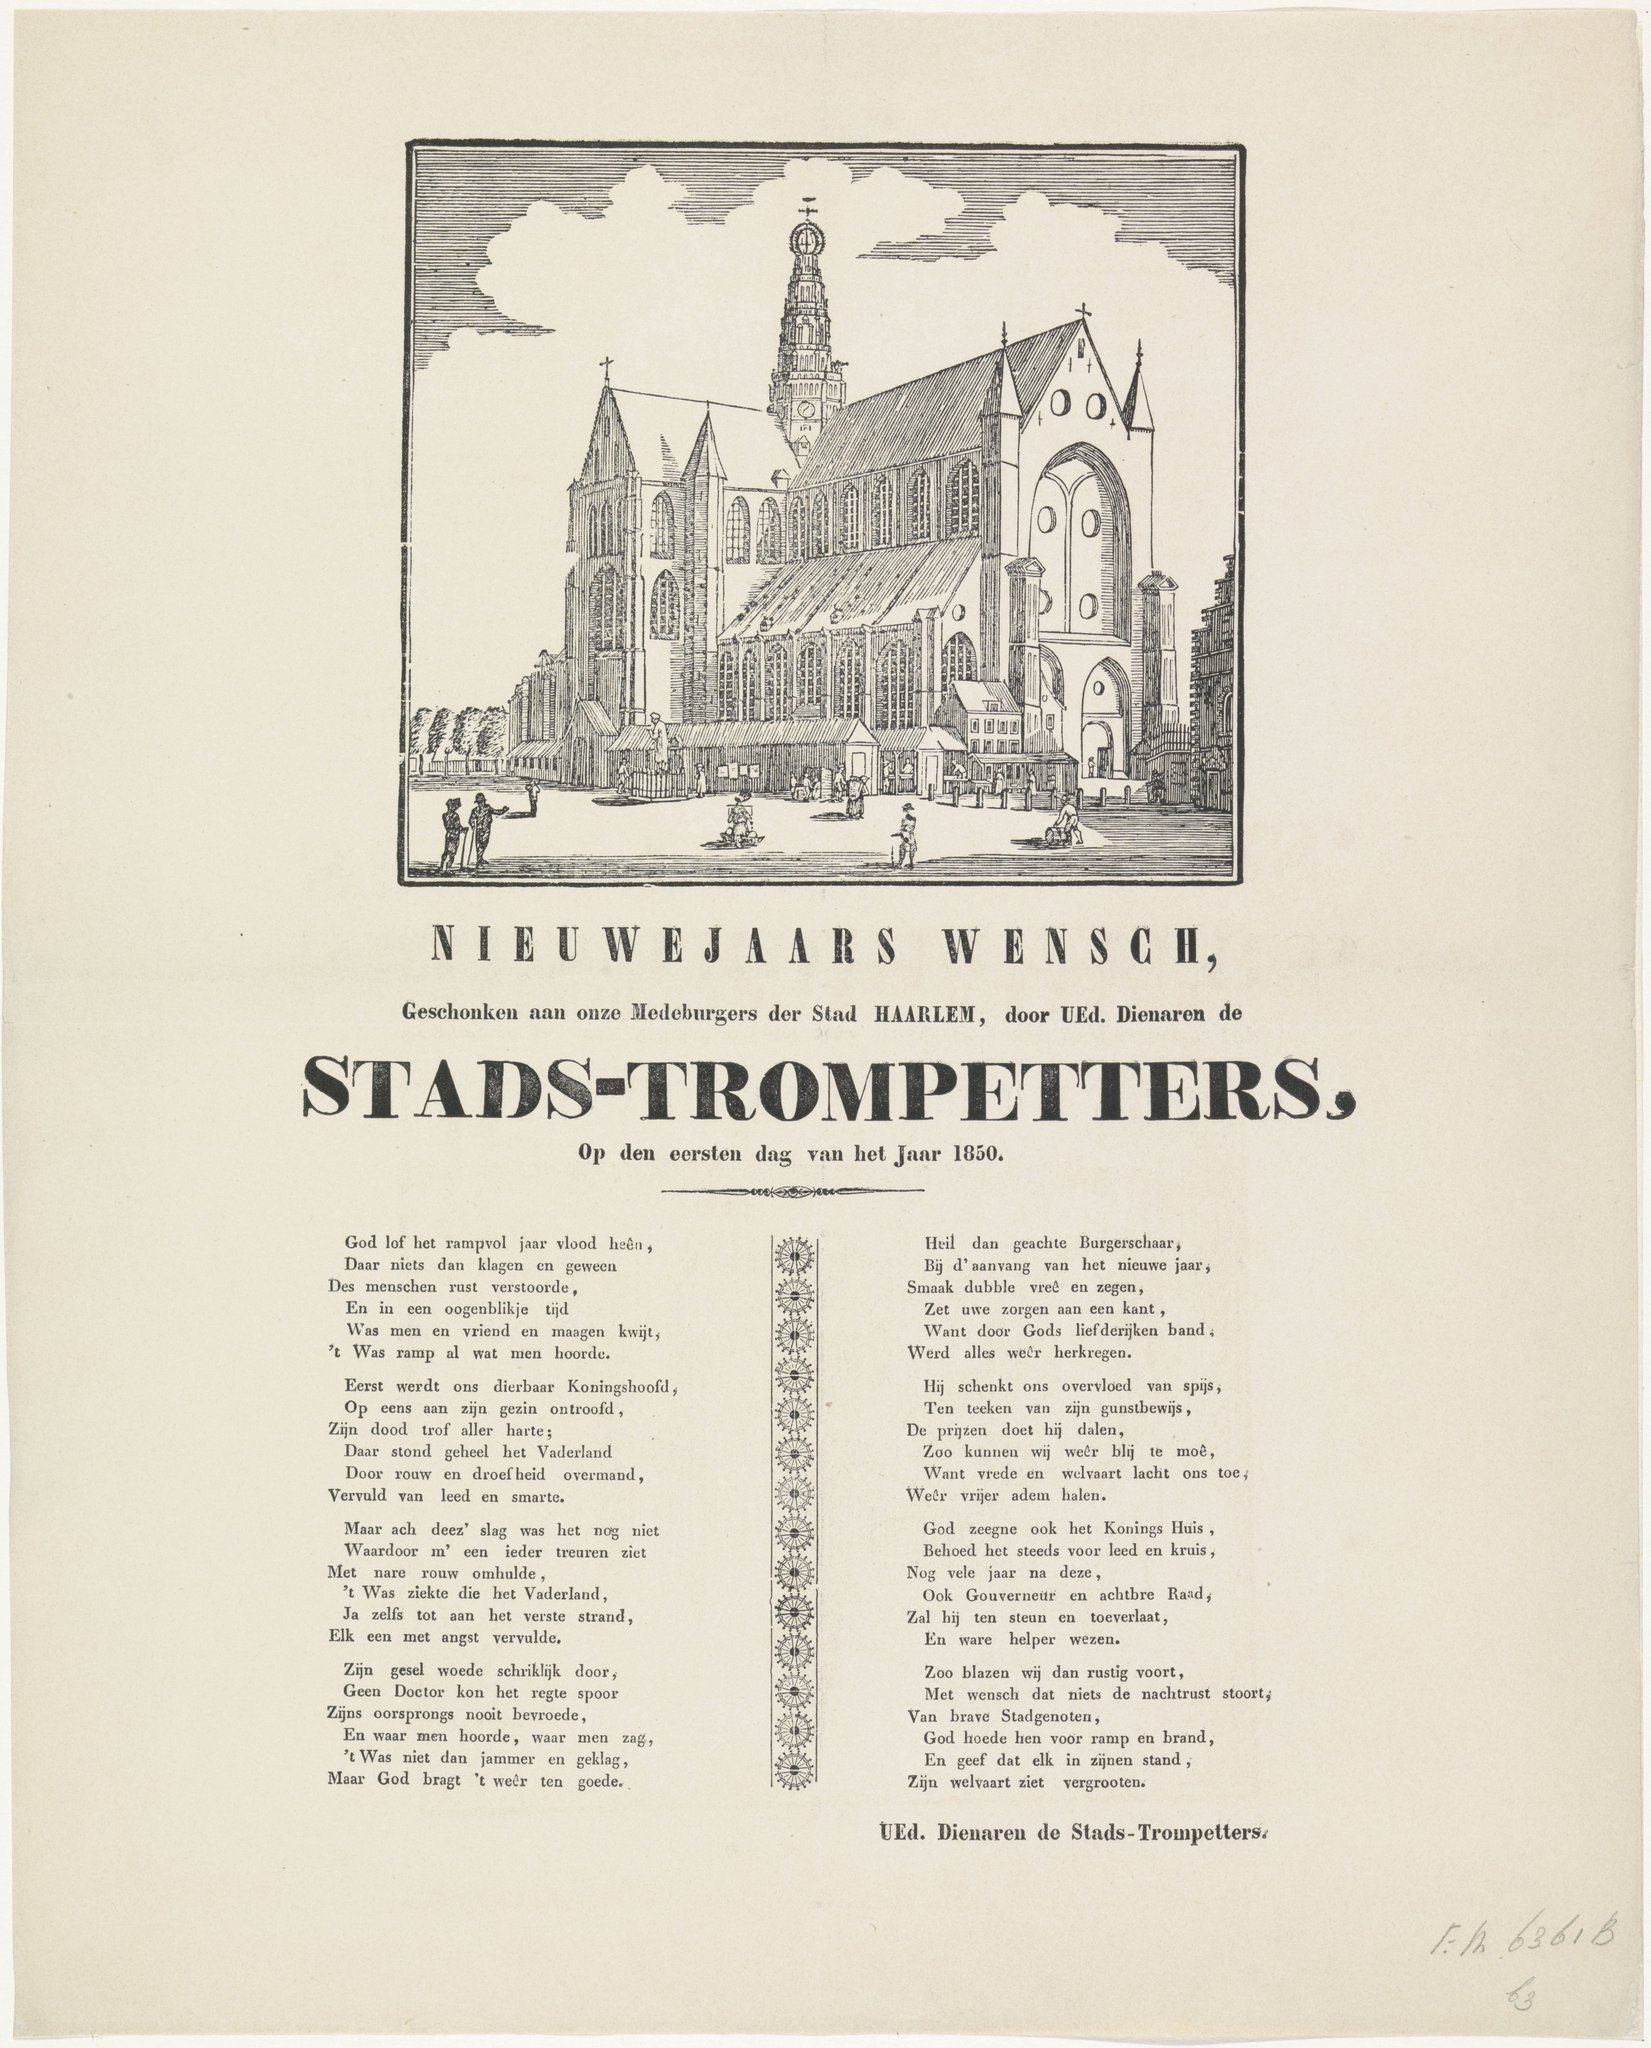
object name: new year card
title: Nieuwjaarswens van de stadstrompetters van Haarlem voor het jaar 1850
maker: Anonymous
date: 1849-1850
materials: paper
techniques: letterpress printing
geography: haarlem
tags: tower sentry, church (exterior), street, haarlem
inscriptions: collector's mark: Lugt 2228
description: Nieuwjaarswens van de Haarlemse torenwachters (stadstrompetters) voor het jaar 1850. Gezicht op de Grote Markte te Haarlem met een torenwacht op de toren van de Sint-Bavo. Met een vers in twee kolommen.